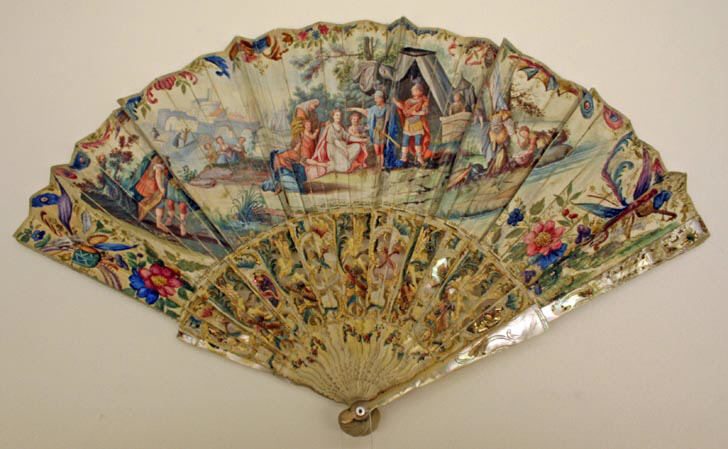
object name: fan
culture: french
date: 1701-1800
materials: mother of pearl, paper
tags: men,women,flowers